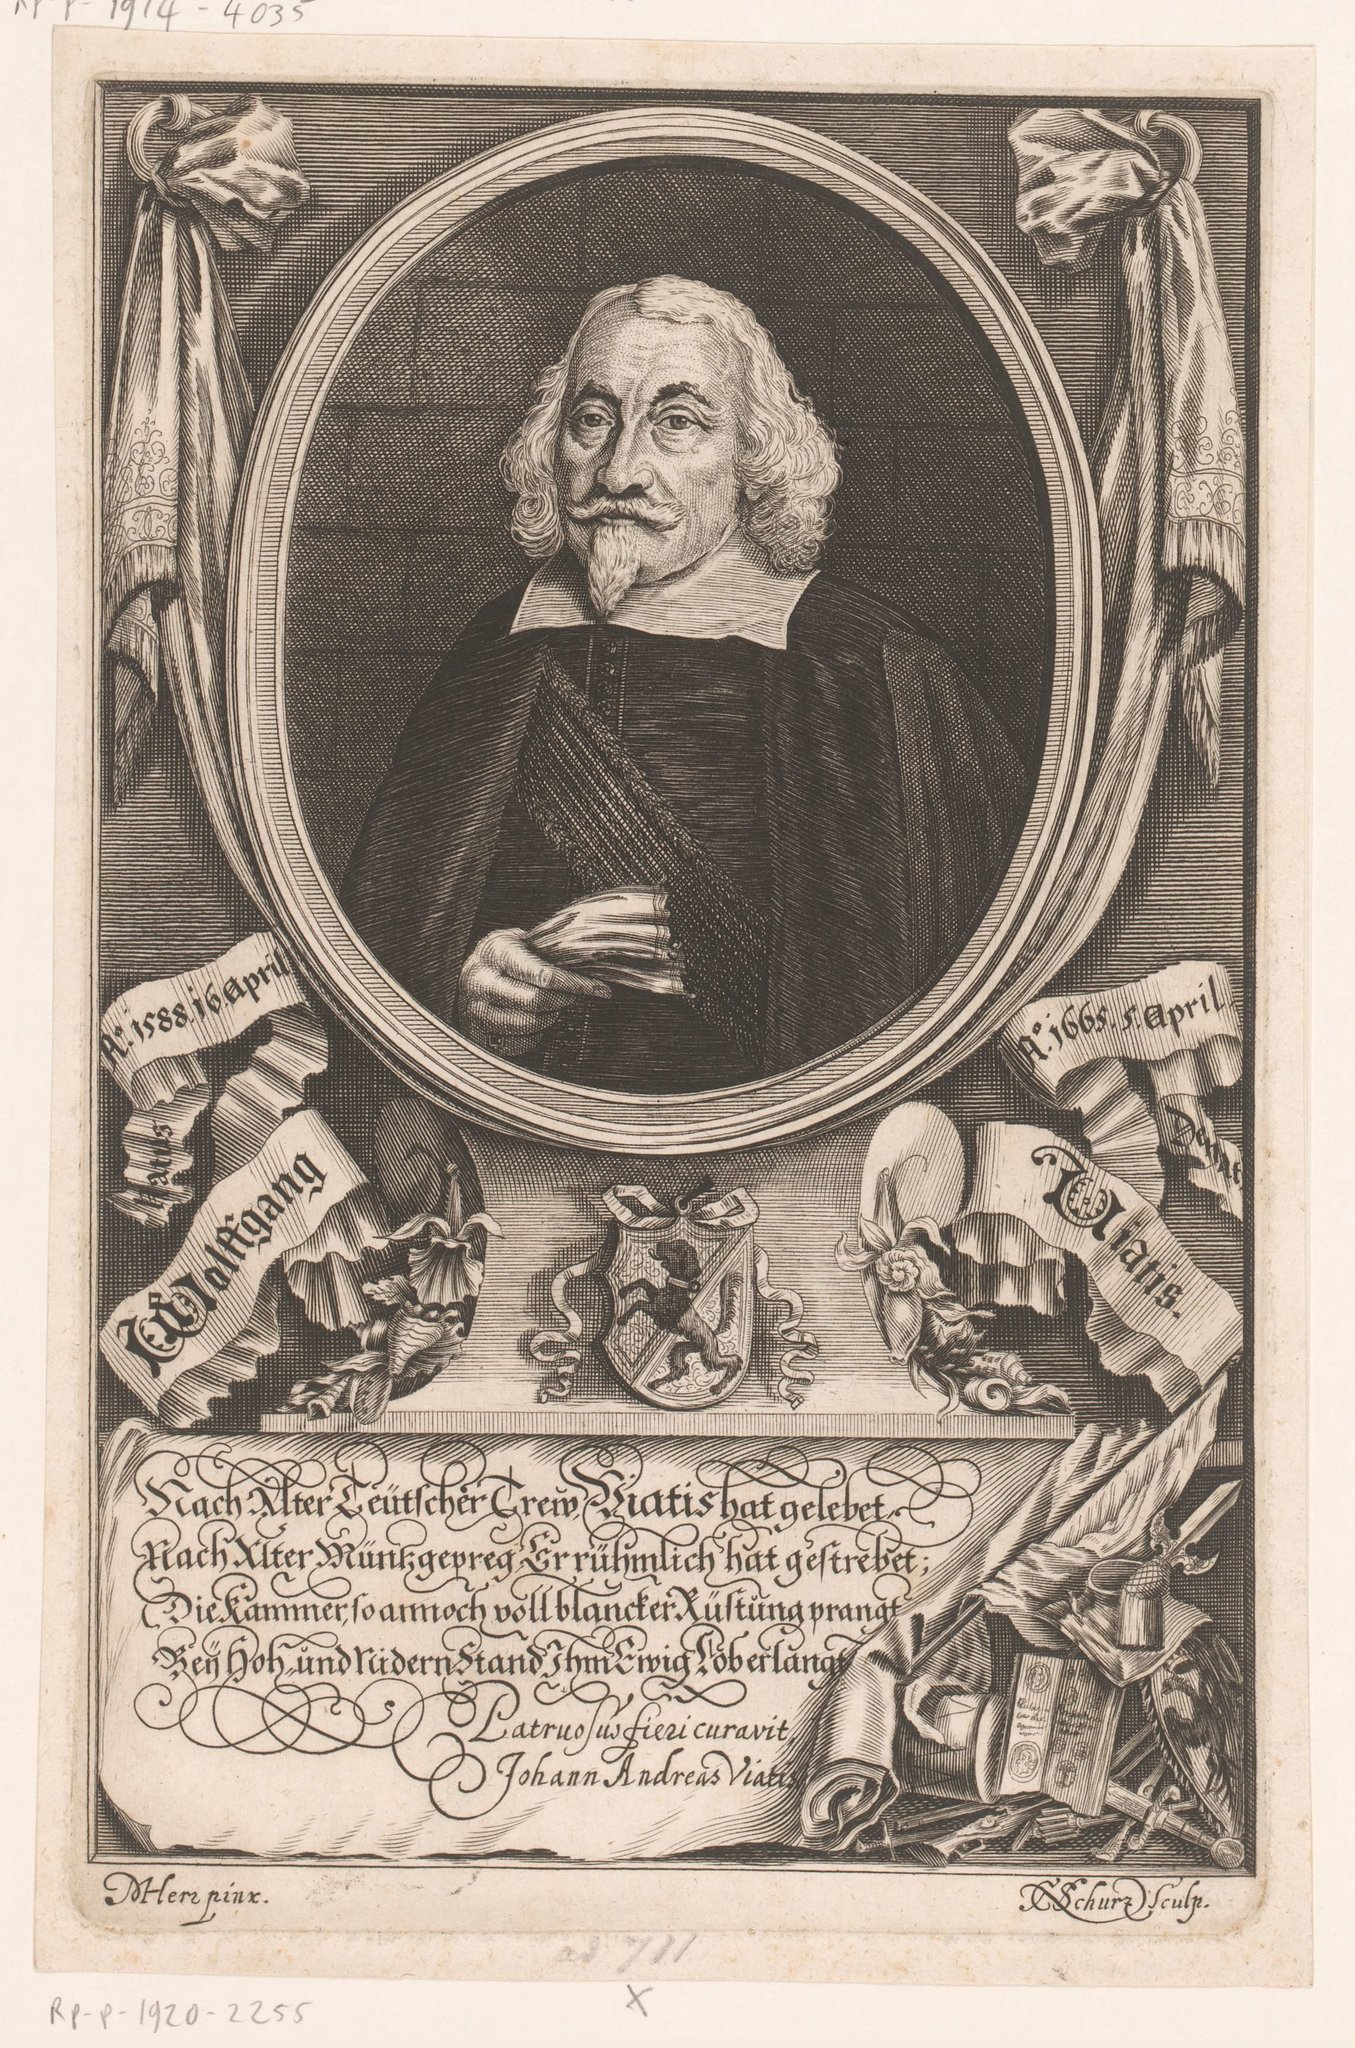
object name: print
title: Portret van Wolffgang Viatis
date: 1665-1699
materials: paper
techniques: engraving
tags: wolfgang viatis, historical persons, symbols, allegories of war; 'guerra' (ripa), armorial bearing, heraldry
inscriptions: collector's mark: Lugt 2228